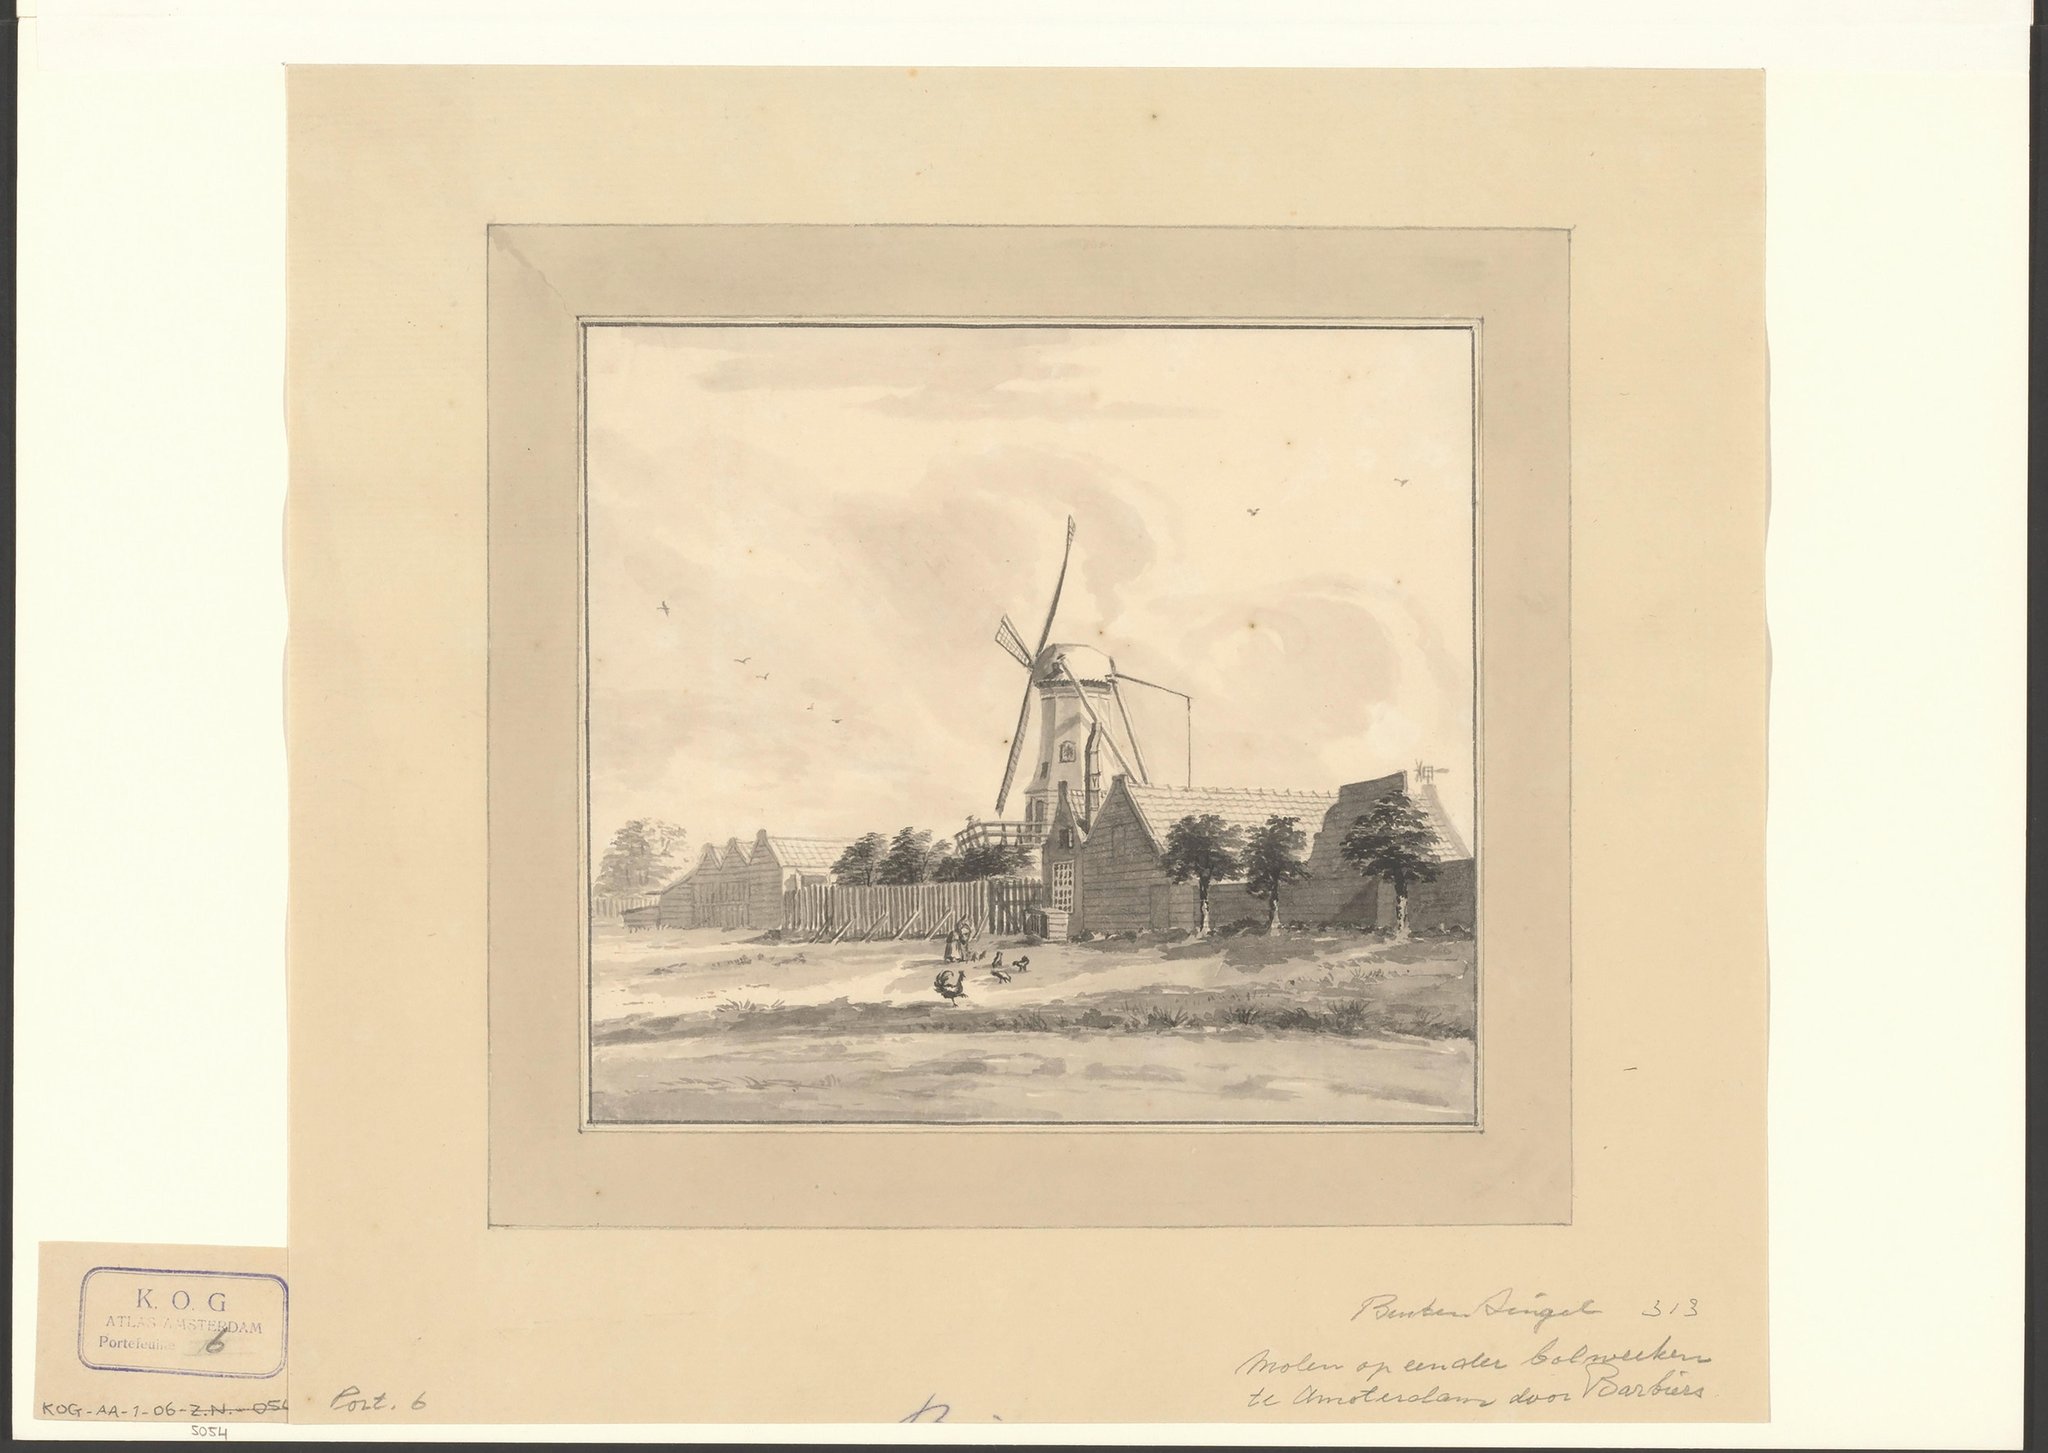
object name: drawing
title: Gezicht op een molen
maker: Anonymous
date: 1750-1799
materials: ink, paper, pencil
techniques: brush, pen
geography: amsterdam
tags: city-view in general; 'veduta', windmill in landscape, amsterdam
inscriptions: inscription: ‘Buiten Singel 313 / molen op een der bolwerken / te Amsterdam door Barbiers’, inscription: ‘Molen op een der Bolwerken / te Amsterdam door Barbiers/ Buiten singel’, inscription: ‘Port. 6’, collector's mark: ‘6’ Lugt 1641b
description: Onderwerpsrubriek binnen de Atlas Amsterdam: Buitensingel of wel: Gezichten langs en op de Stadsvest van Haarlemmerpoort tot Raampoort / Raampoort tot Zeeburgerdijk.